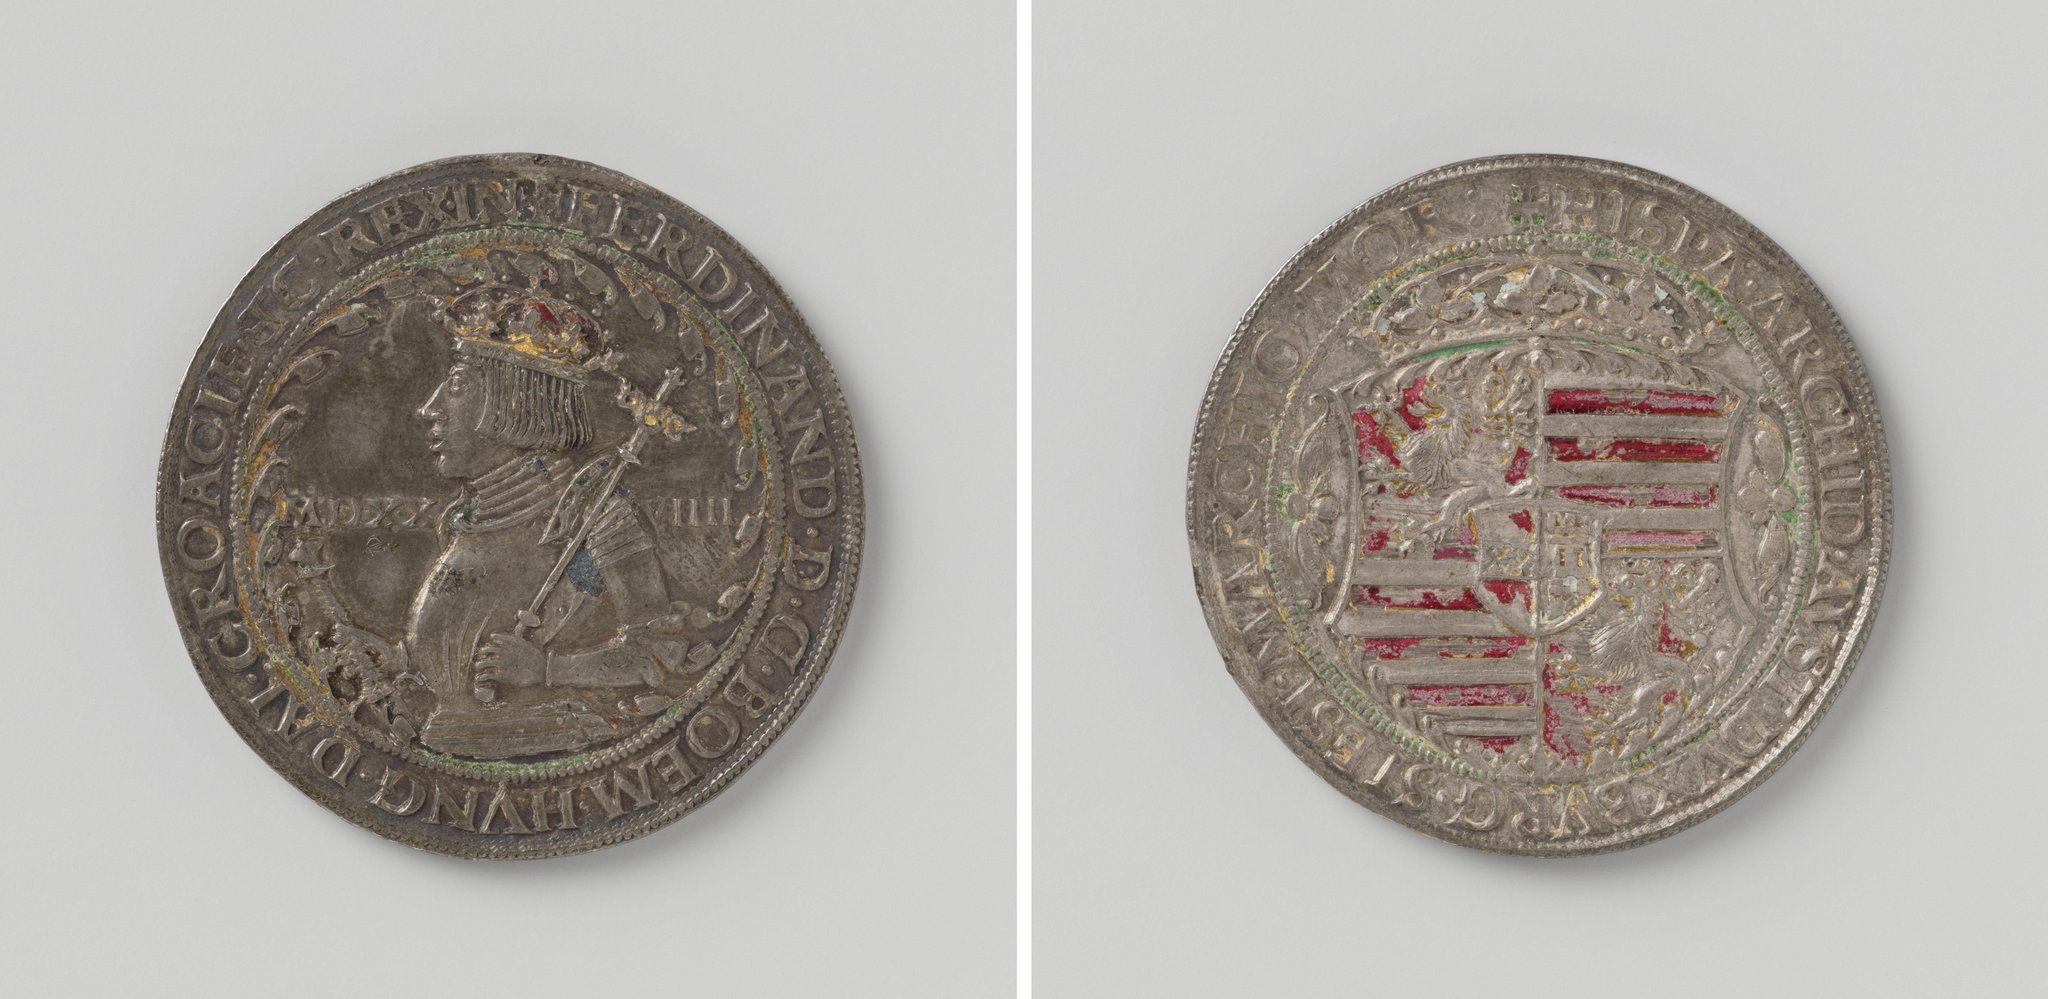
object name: history medal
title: Ferdinand I, koning van Bohemen en Hongarije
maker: Anonymous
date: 1529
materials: paint, silver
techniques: painted, striking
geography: hall am inn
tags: vienna, ferdinand i van habsburg (duits keizer)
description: Zilveren penning. Voorzijde: borststuk man met kroon, zwaard en scepter binnen omschrift. Keerzijde: gekroond wapenschild binnen omschrift